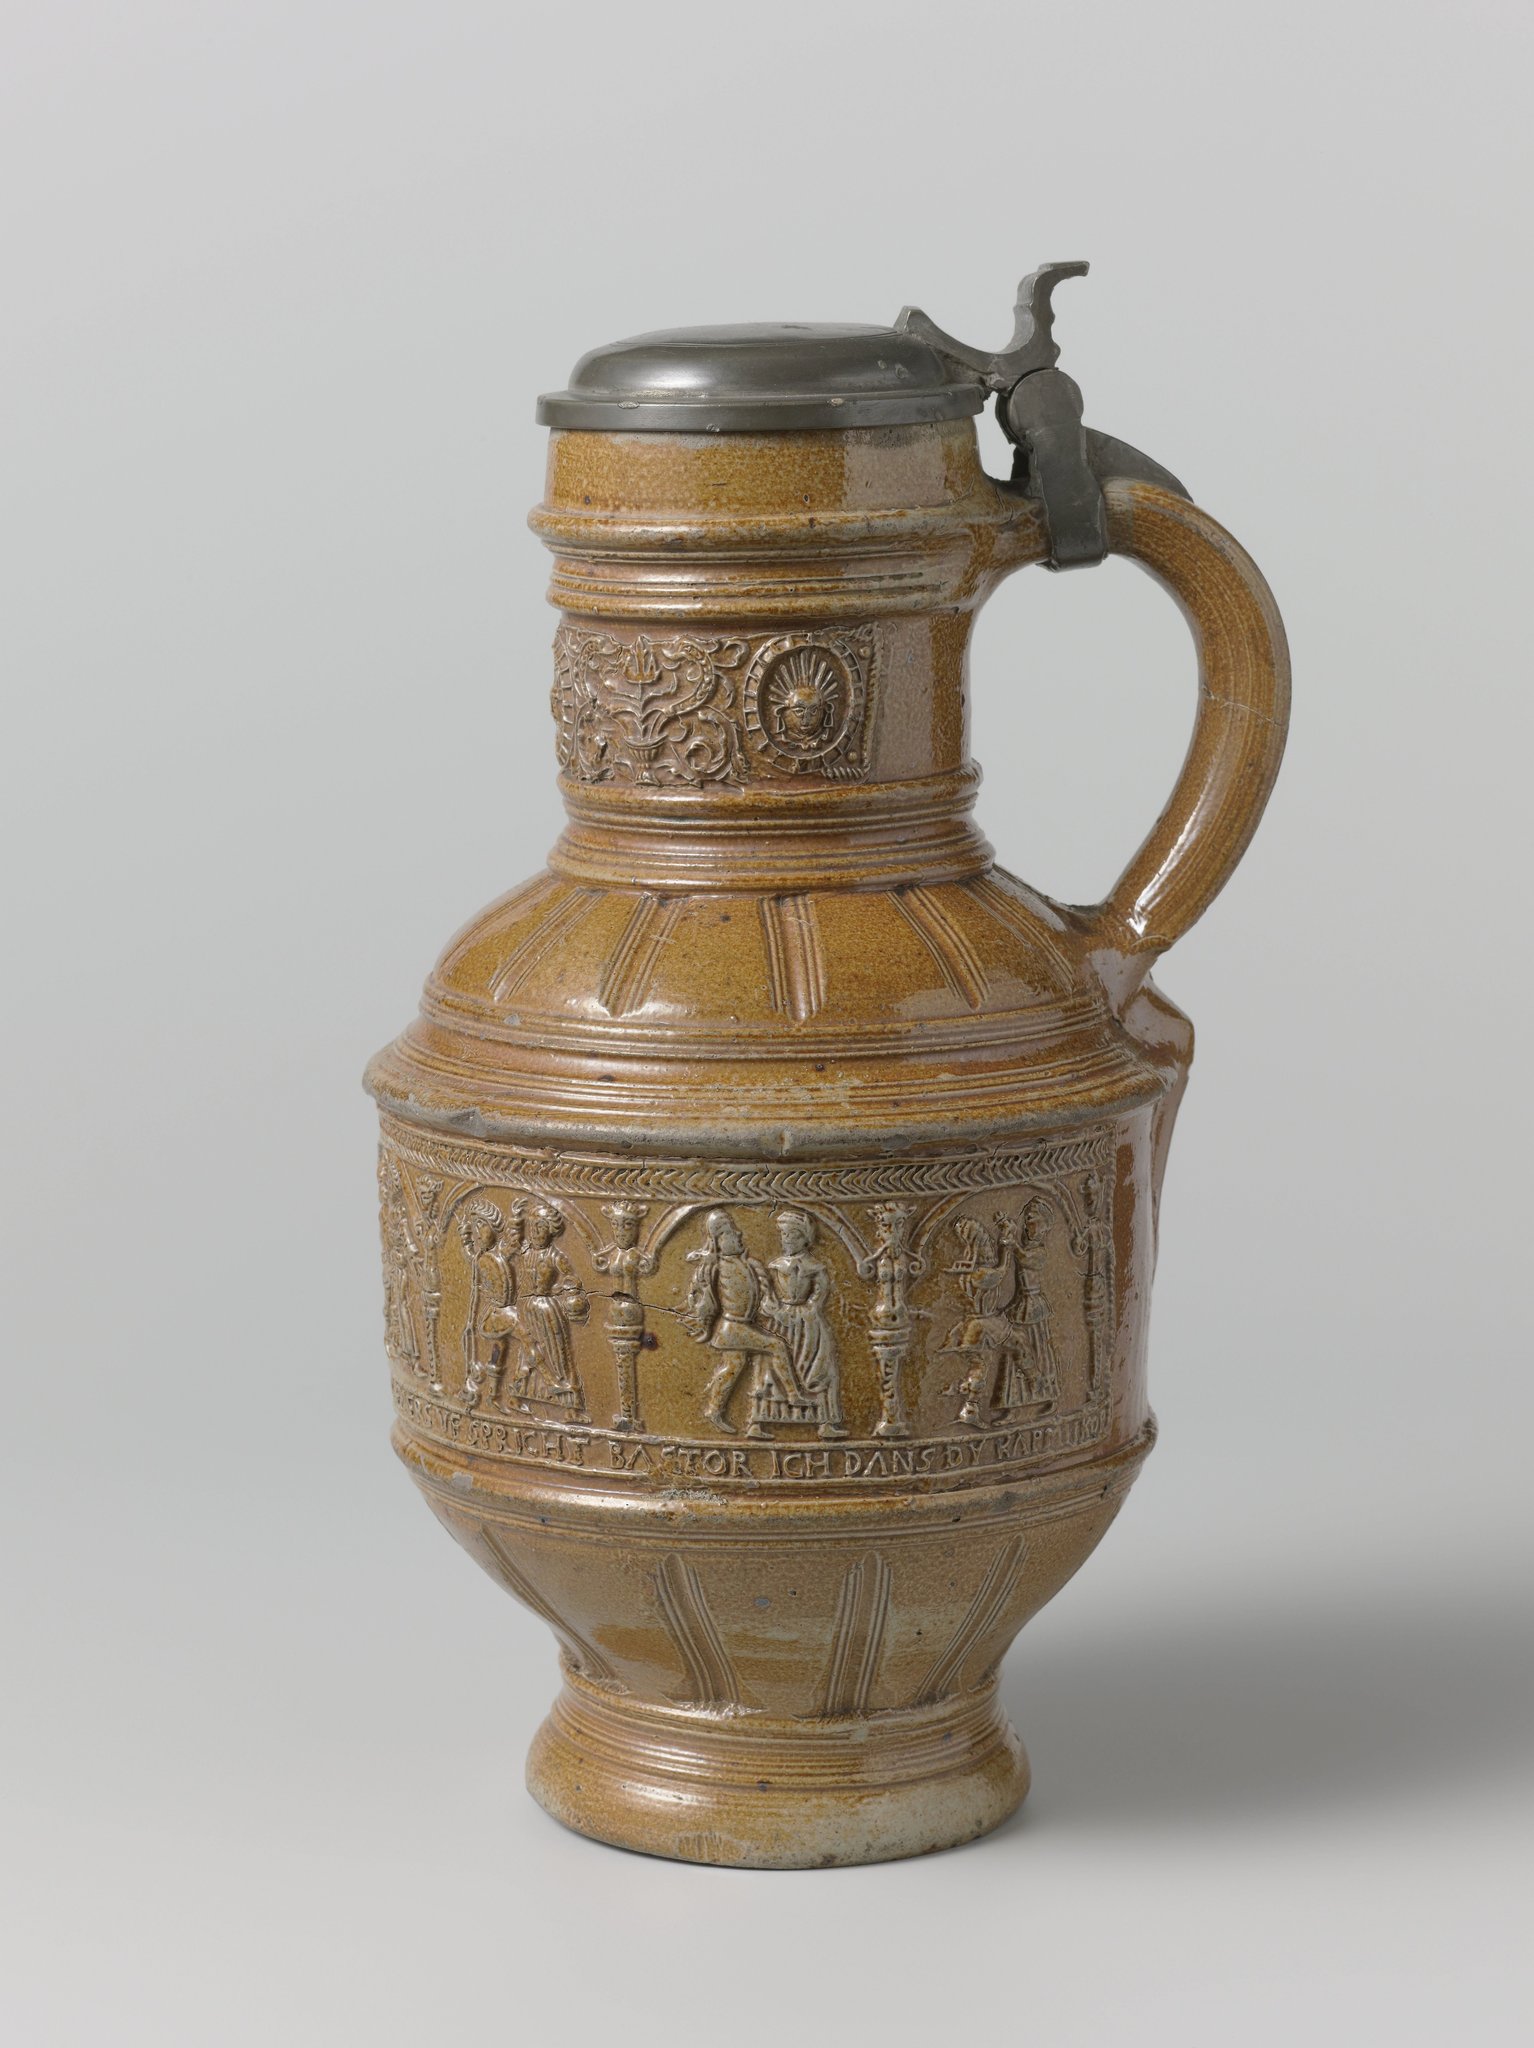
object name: jug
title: Jug with a dancing couple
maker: Anonymous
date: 1597-1605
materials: engobe, glaze, stoneware, tin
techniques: firing, forming, relief, turning, vitrification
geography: raeren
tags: coat of arms (as symbol of the state, etc.) (+ city; municipal), one pair dancing; man and woman dancing as a couple, amsterdam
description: translation of inscription: Gerrit, you must blow mightily: the peasants dance like crazy: Cool off, says the priest, I dance away my cap, amice and cope